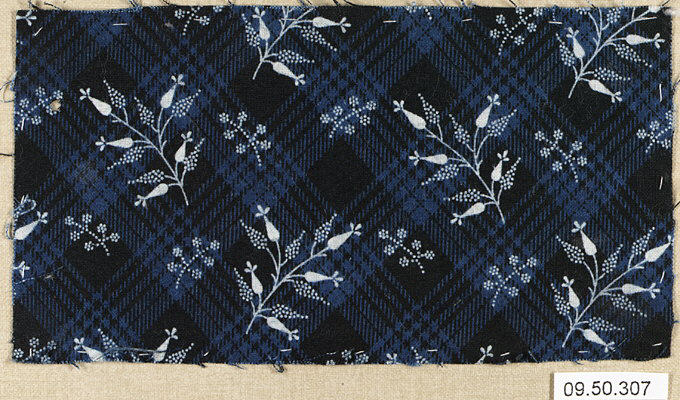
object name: piece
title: Piece (one of 116)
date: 1801-1900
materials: cotton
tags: flowers